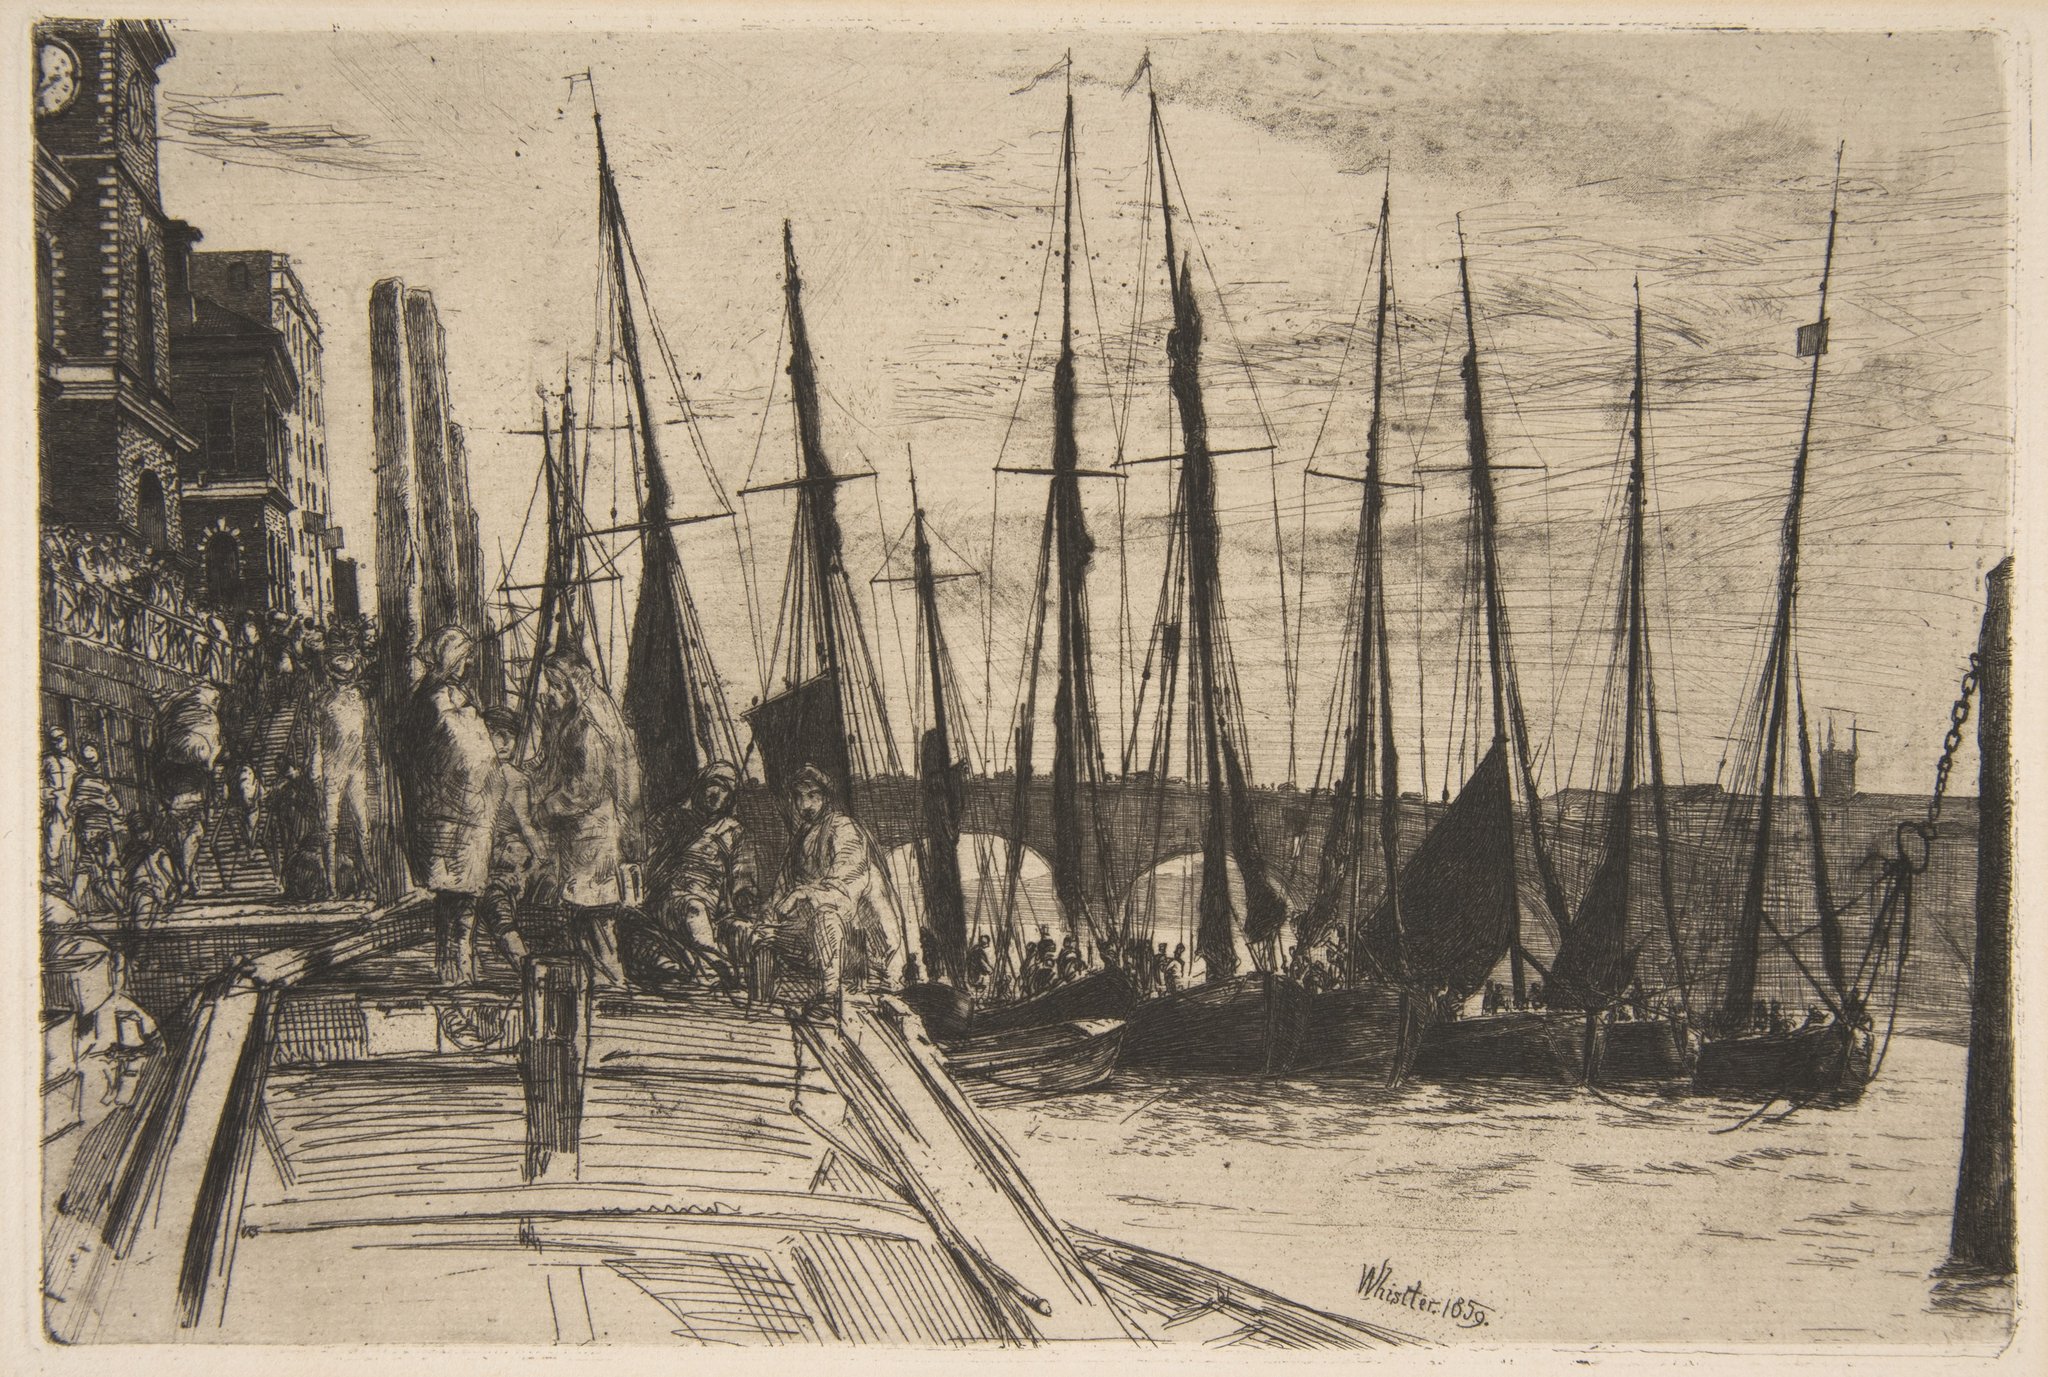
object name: print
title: Billingsgate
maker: james mcneill whistler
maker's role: artist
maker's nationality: american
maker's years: 1834-1903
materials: ink, paper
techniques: drypoint, etching, printing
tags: buildings,men,boats,london